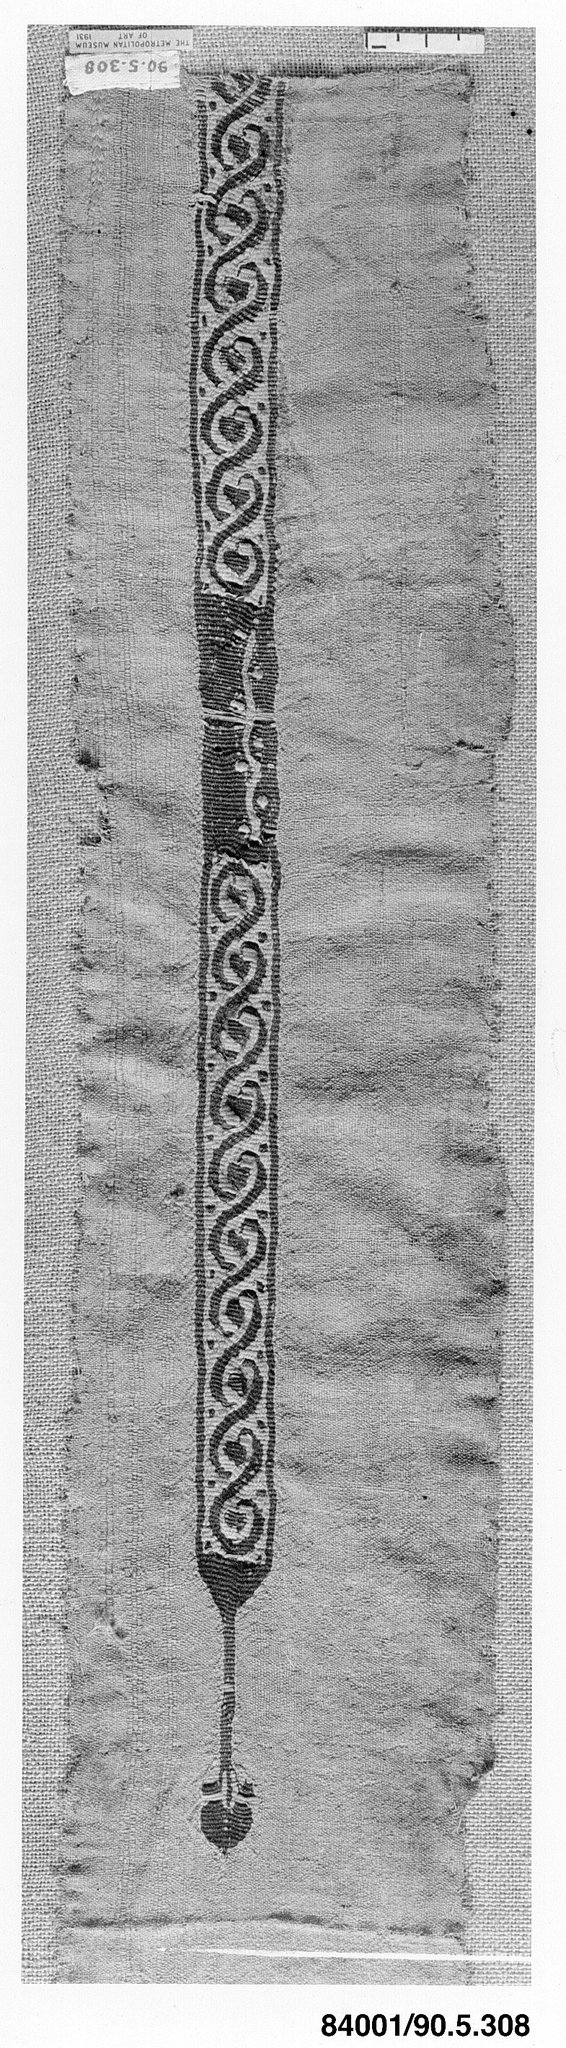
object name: textile fragment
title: Fragment of a Tunic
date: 201-400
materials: linen, wool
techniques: weave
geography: egypt